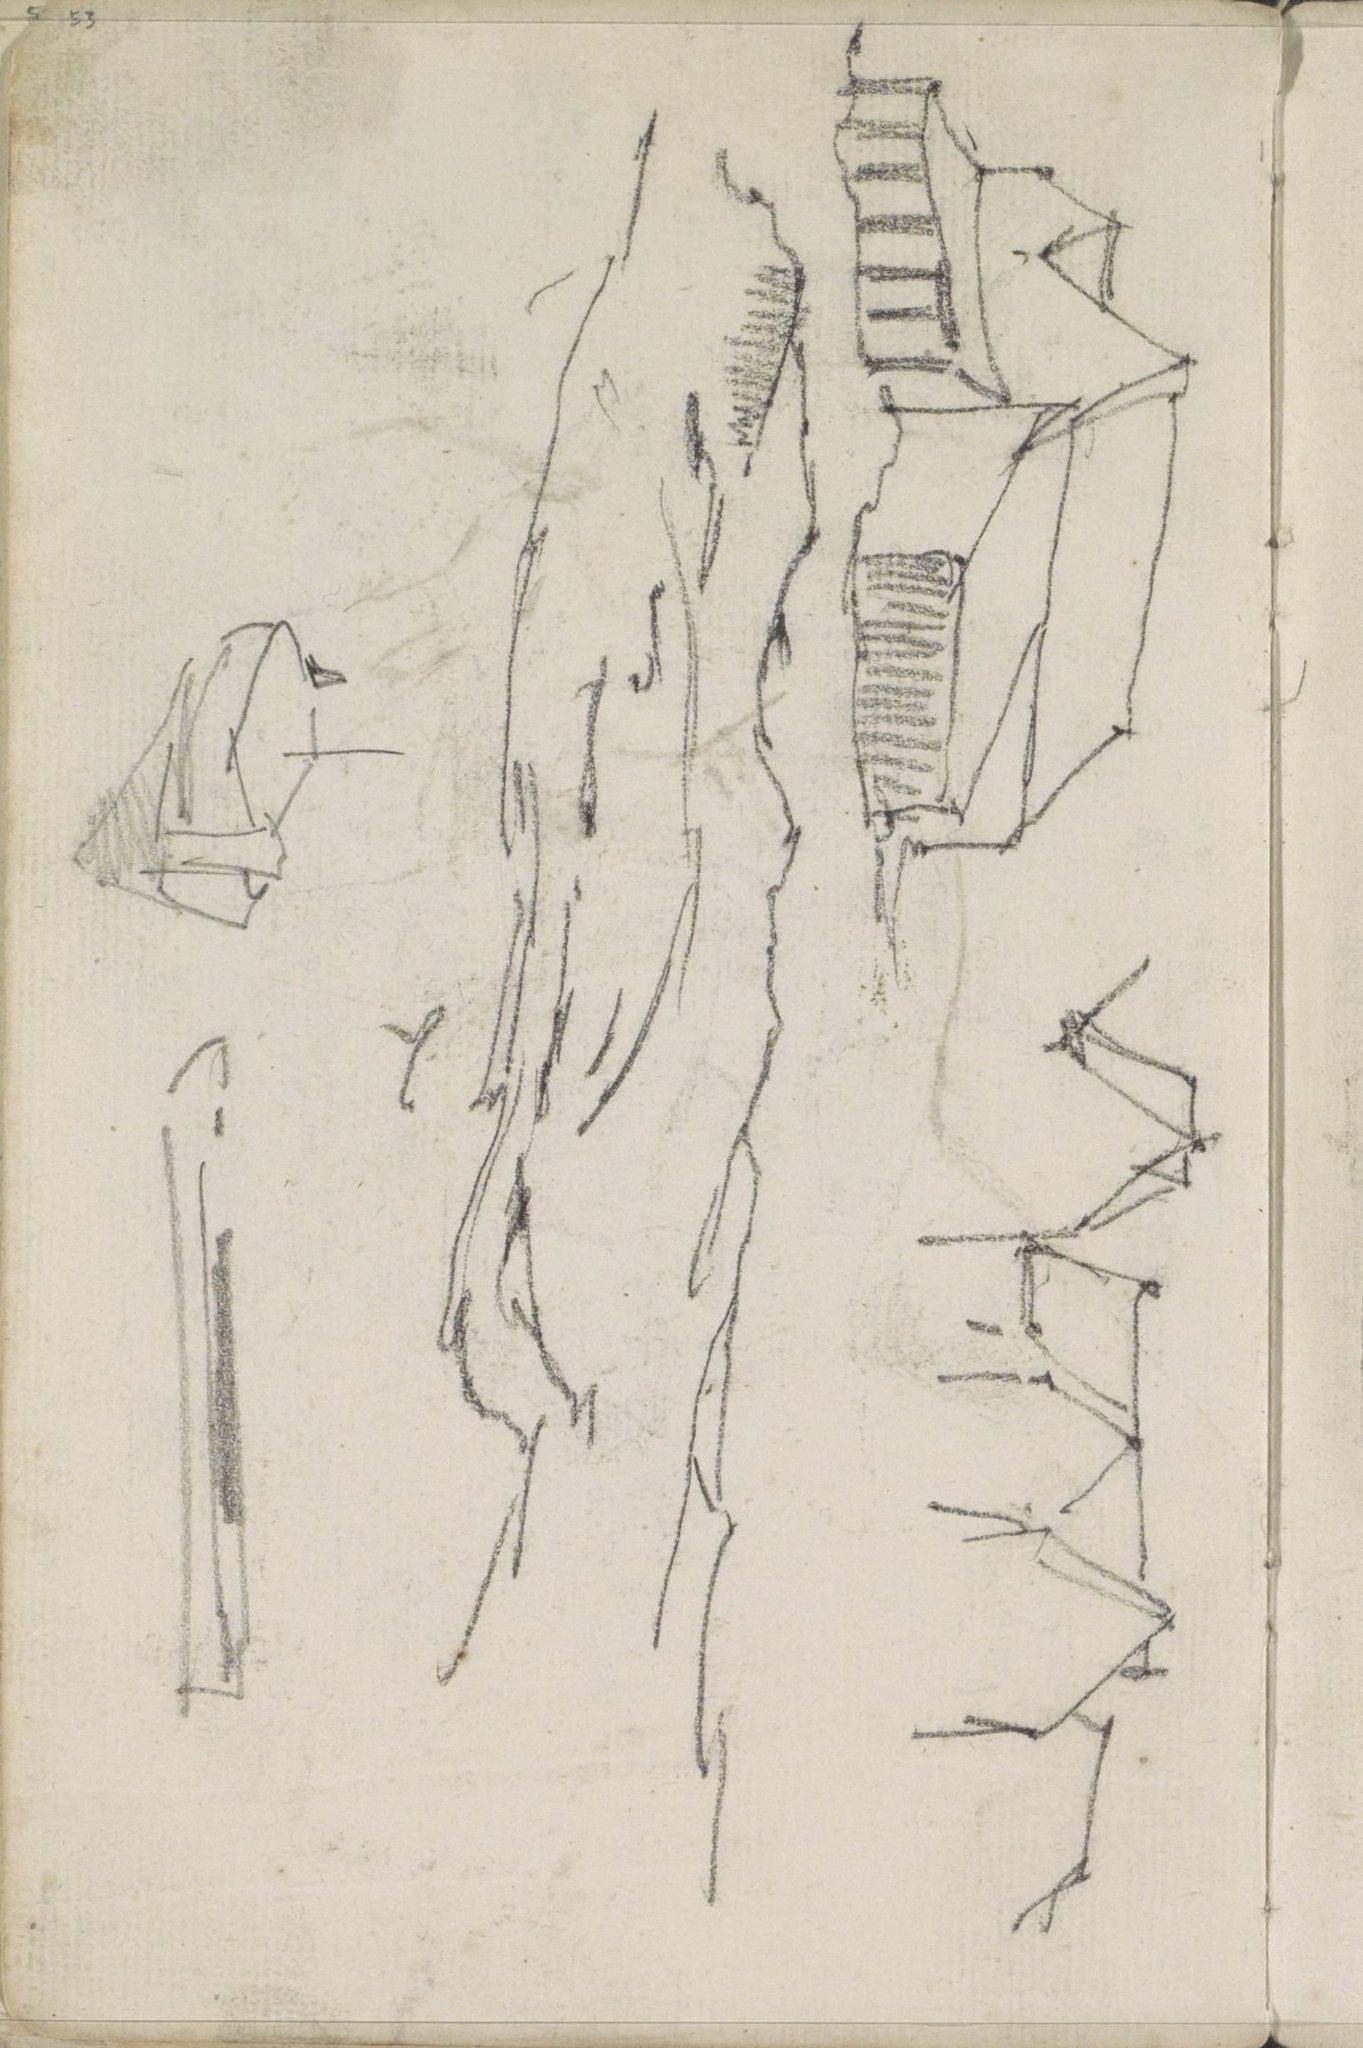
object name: sketchbook leaf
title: Landschap met bebouwing en twee boten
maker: george hendrik breitner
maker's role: draughtsman, painter, print maker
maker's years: 1857-1923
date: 1880-1882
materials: chalk, paper, pencil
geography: the hague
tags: landscapes, ships (in general), civic architecture; edifices; dwellings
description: Pagina 53 uit een schetsboek met 29 bladen.